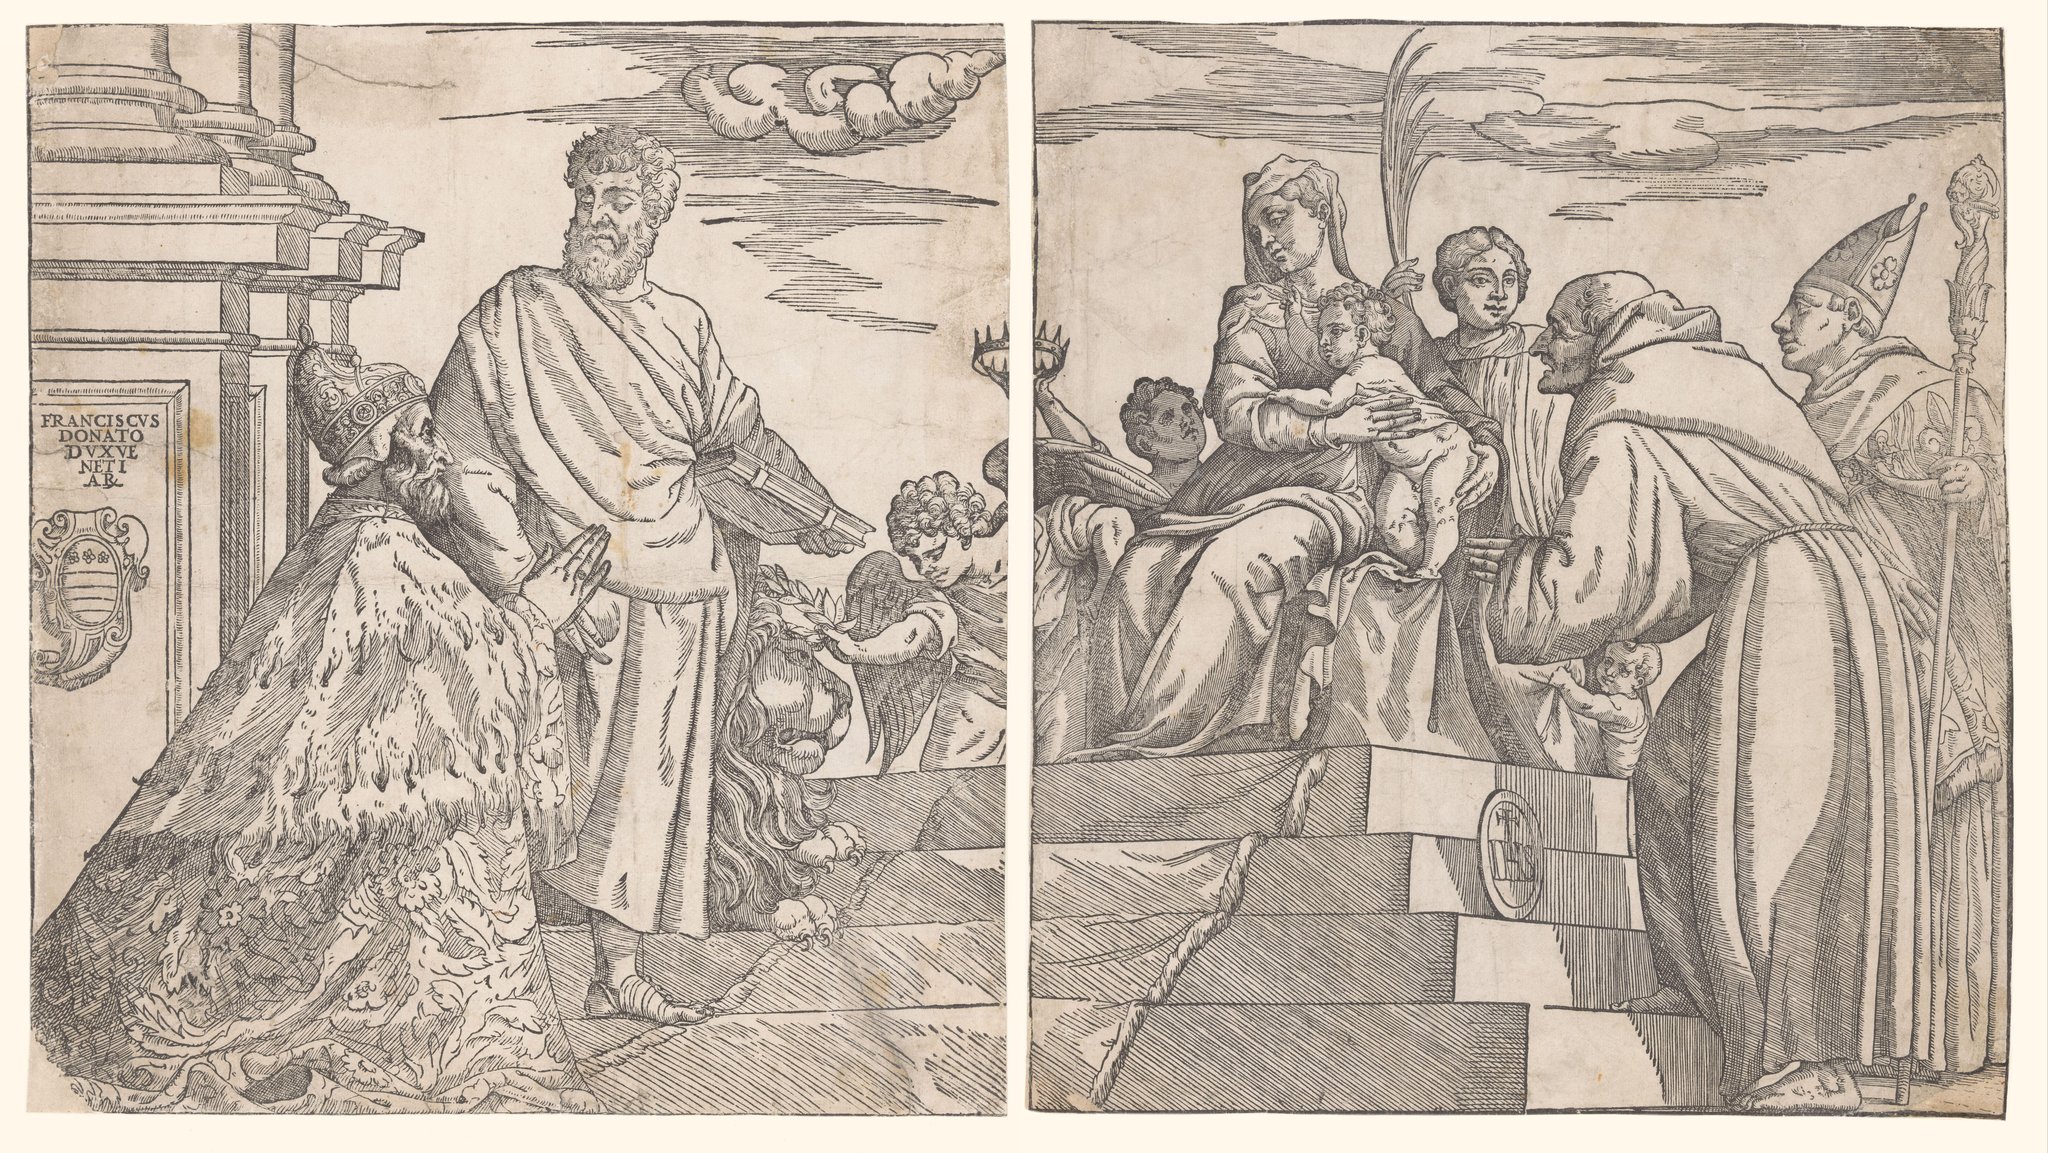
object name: print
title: Doge Francesco Donato knielt voor Maria en Christus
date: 1545-1553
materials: paper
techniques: woodcut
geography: venice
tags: madonna: i.e. mary with the christ-child, ihs ('iesus hominum salvator') ~ symbol of christ, angels crowning and/or bringing palm-branches, mark (marcus) the evangelist, and bishop of alexandria; possible attributes: book, (winged) lion, pen and inkhorn, scroll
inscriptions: collector's mark: Lugt 240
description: De doge van Venetië Francesco Donato, knielend voor Maria en het Christuskind die op een verhoging zitten en worden omringd door heiligen en engelen. Naast de doge staat de heilige Marcus, de beschermheilige van de stad Venetië.